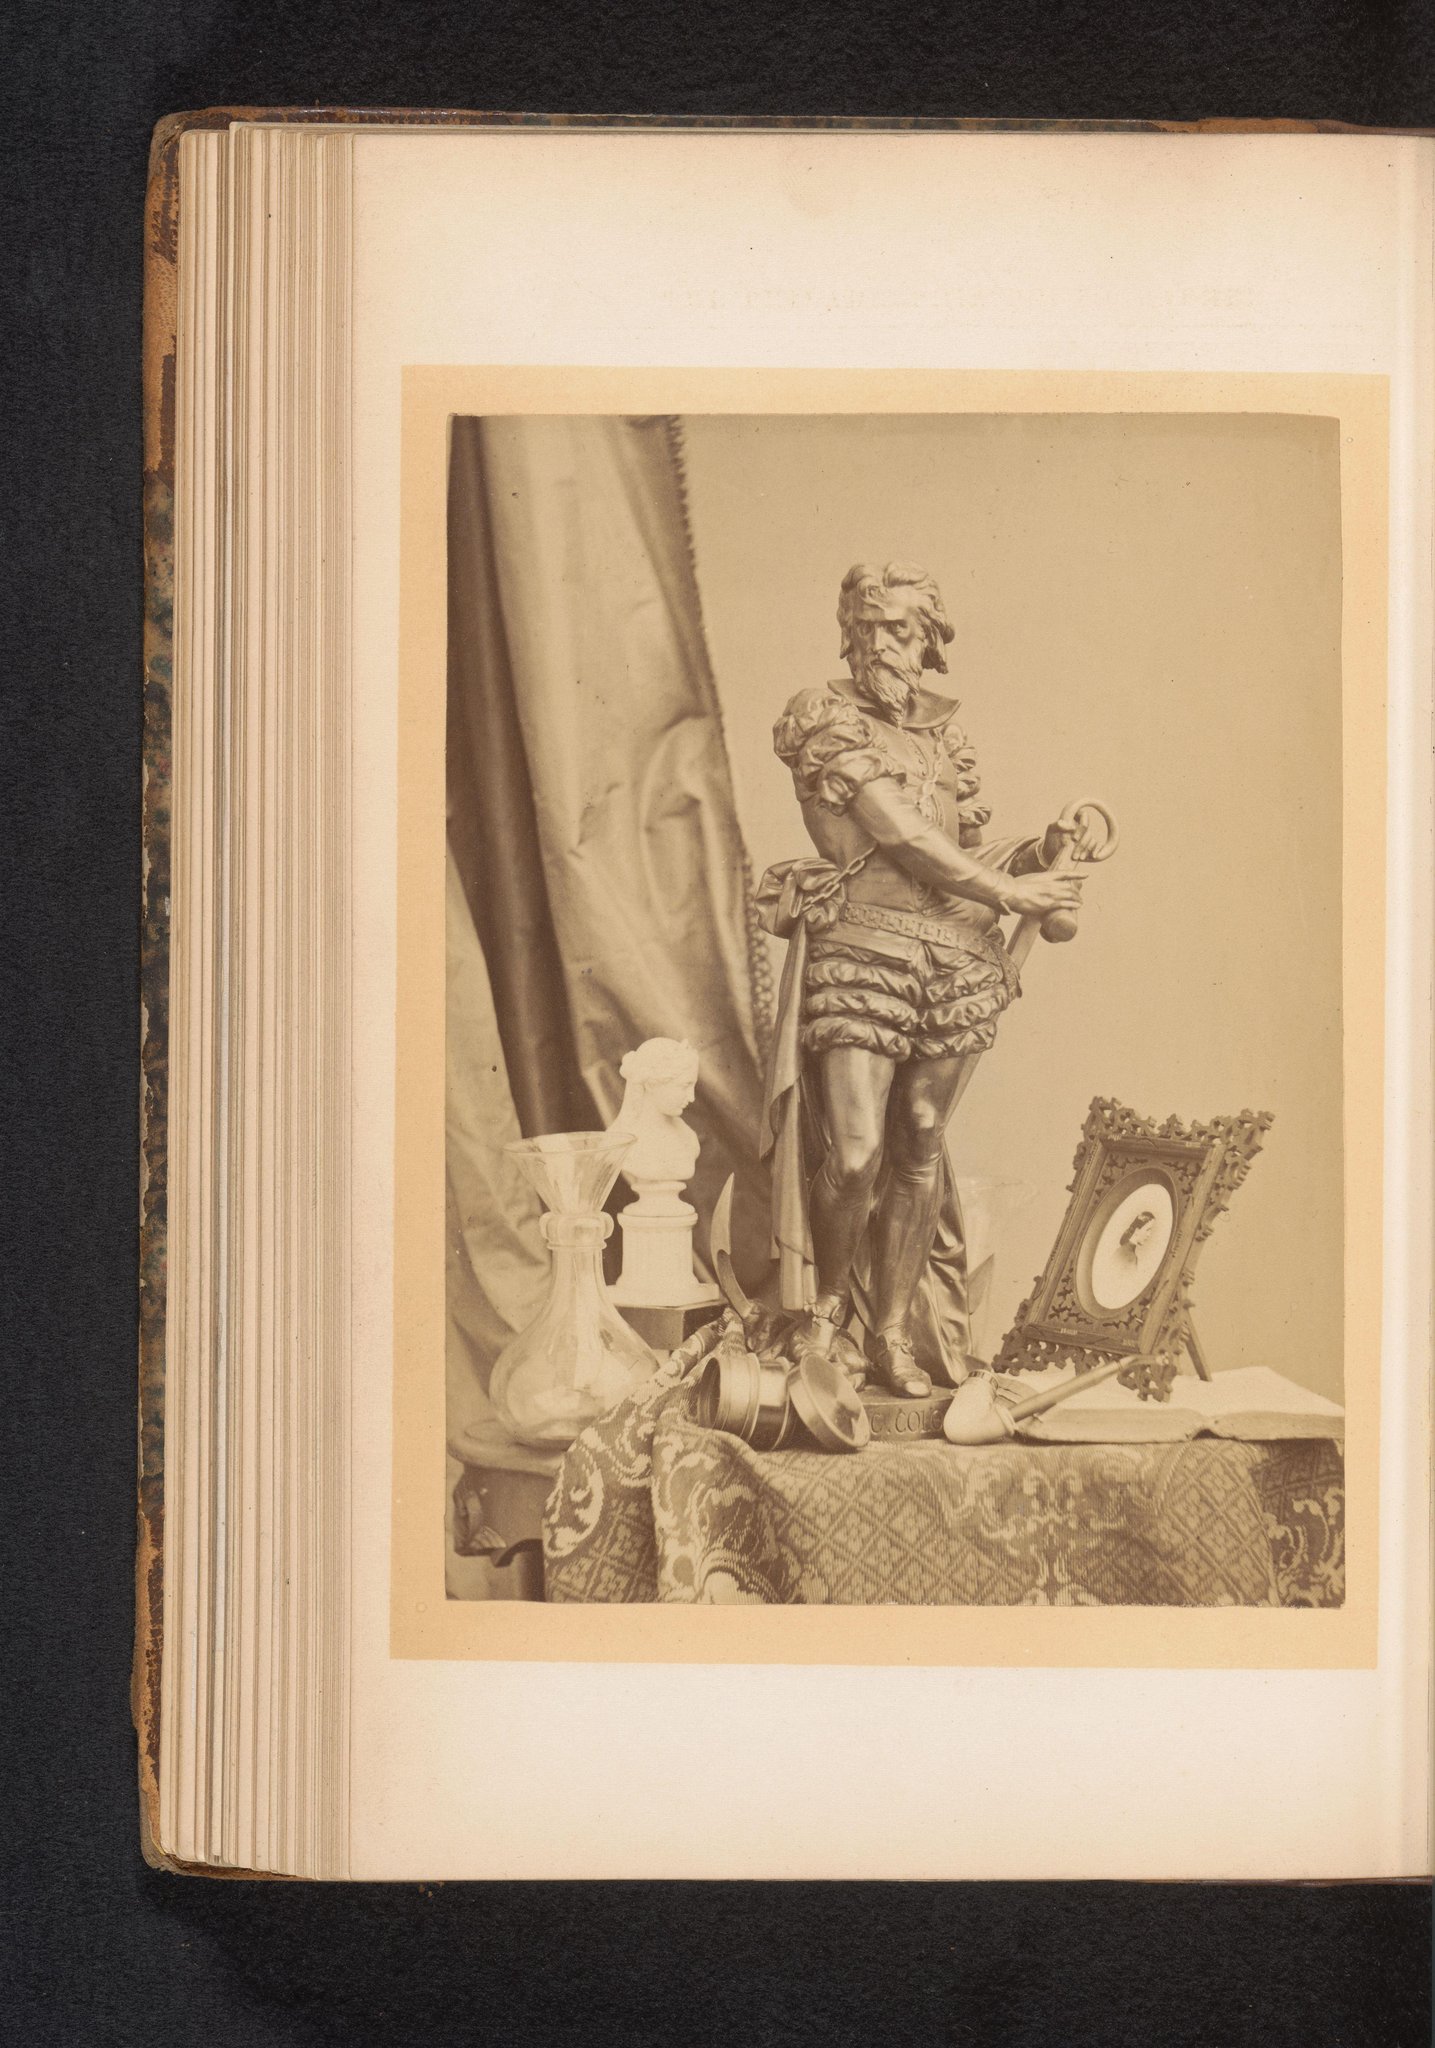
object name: page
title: Bronzen beeld, fotolijst, pijp en andere spullen op een tafel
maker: frederick a. wenderoth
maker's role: painter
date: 1861-1866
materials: photographic support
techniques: albumen print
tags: pipe ~ tobacco, sculpture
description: Foto tegenover pagina 257, achter semi-transparante omslag.